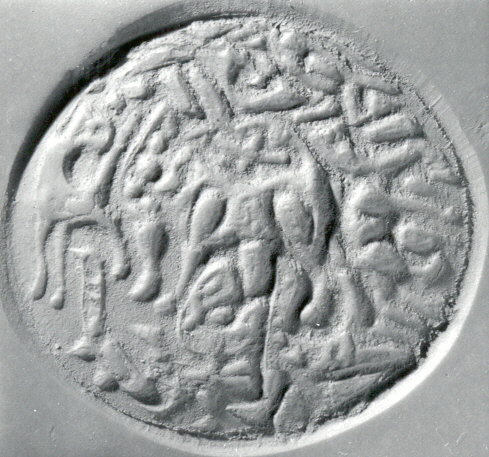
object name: stamp seal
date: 1001-2000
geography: eastern iran (?)